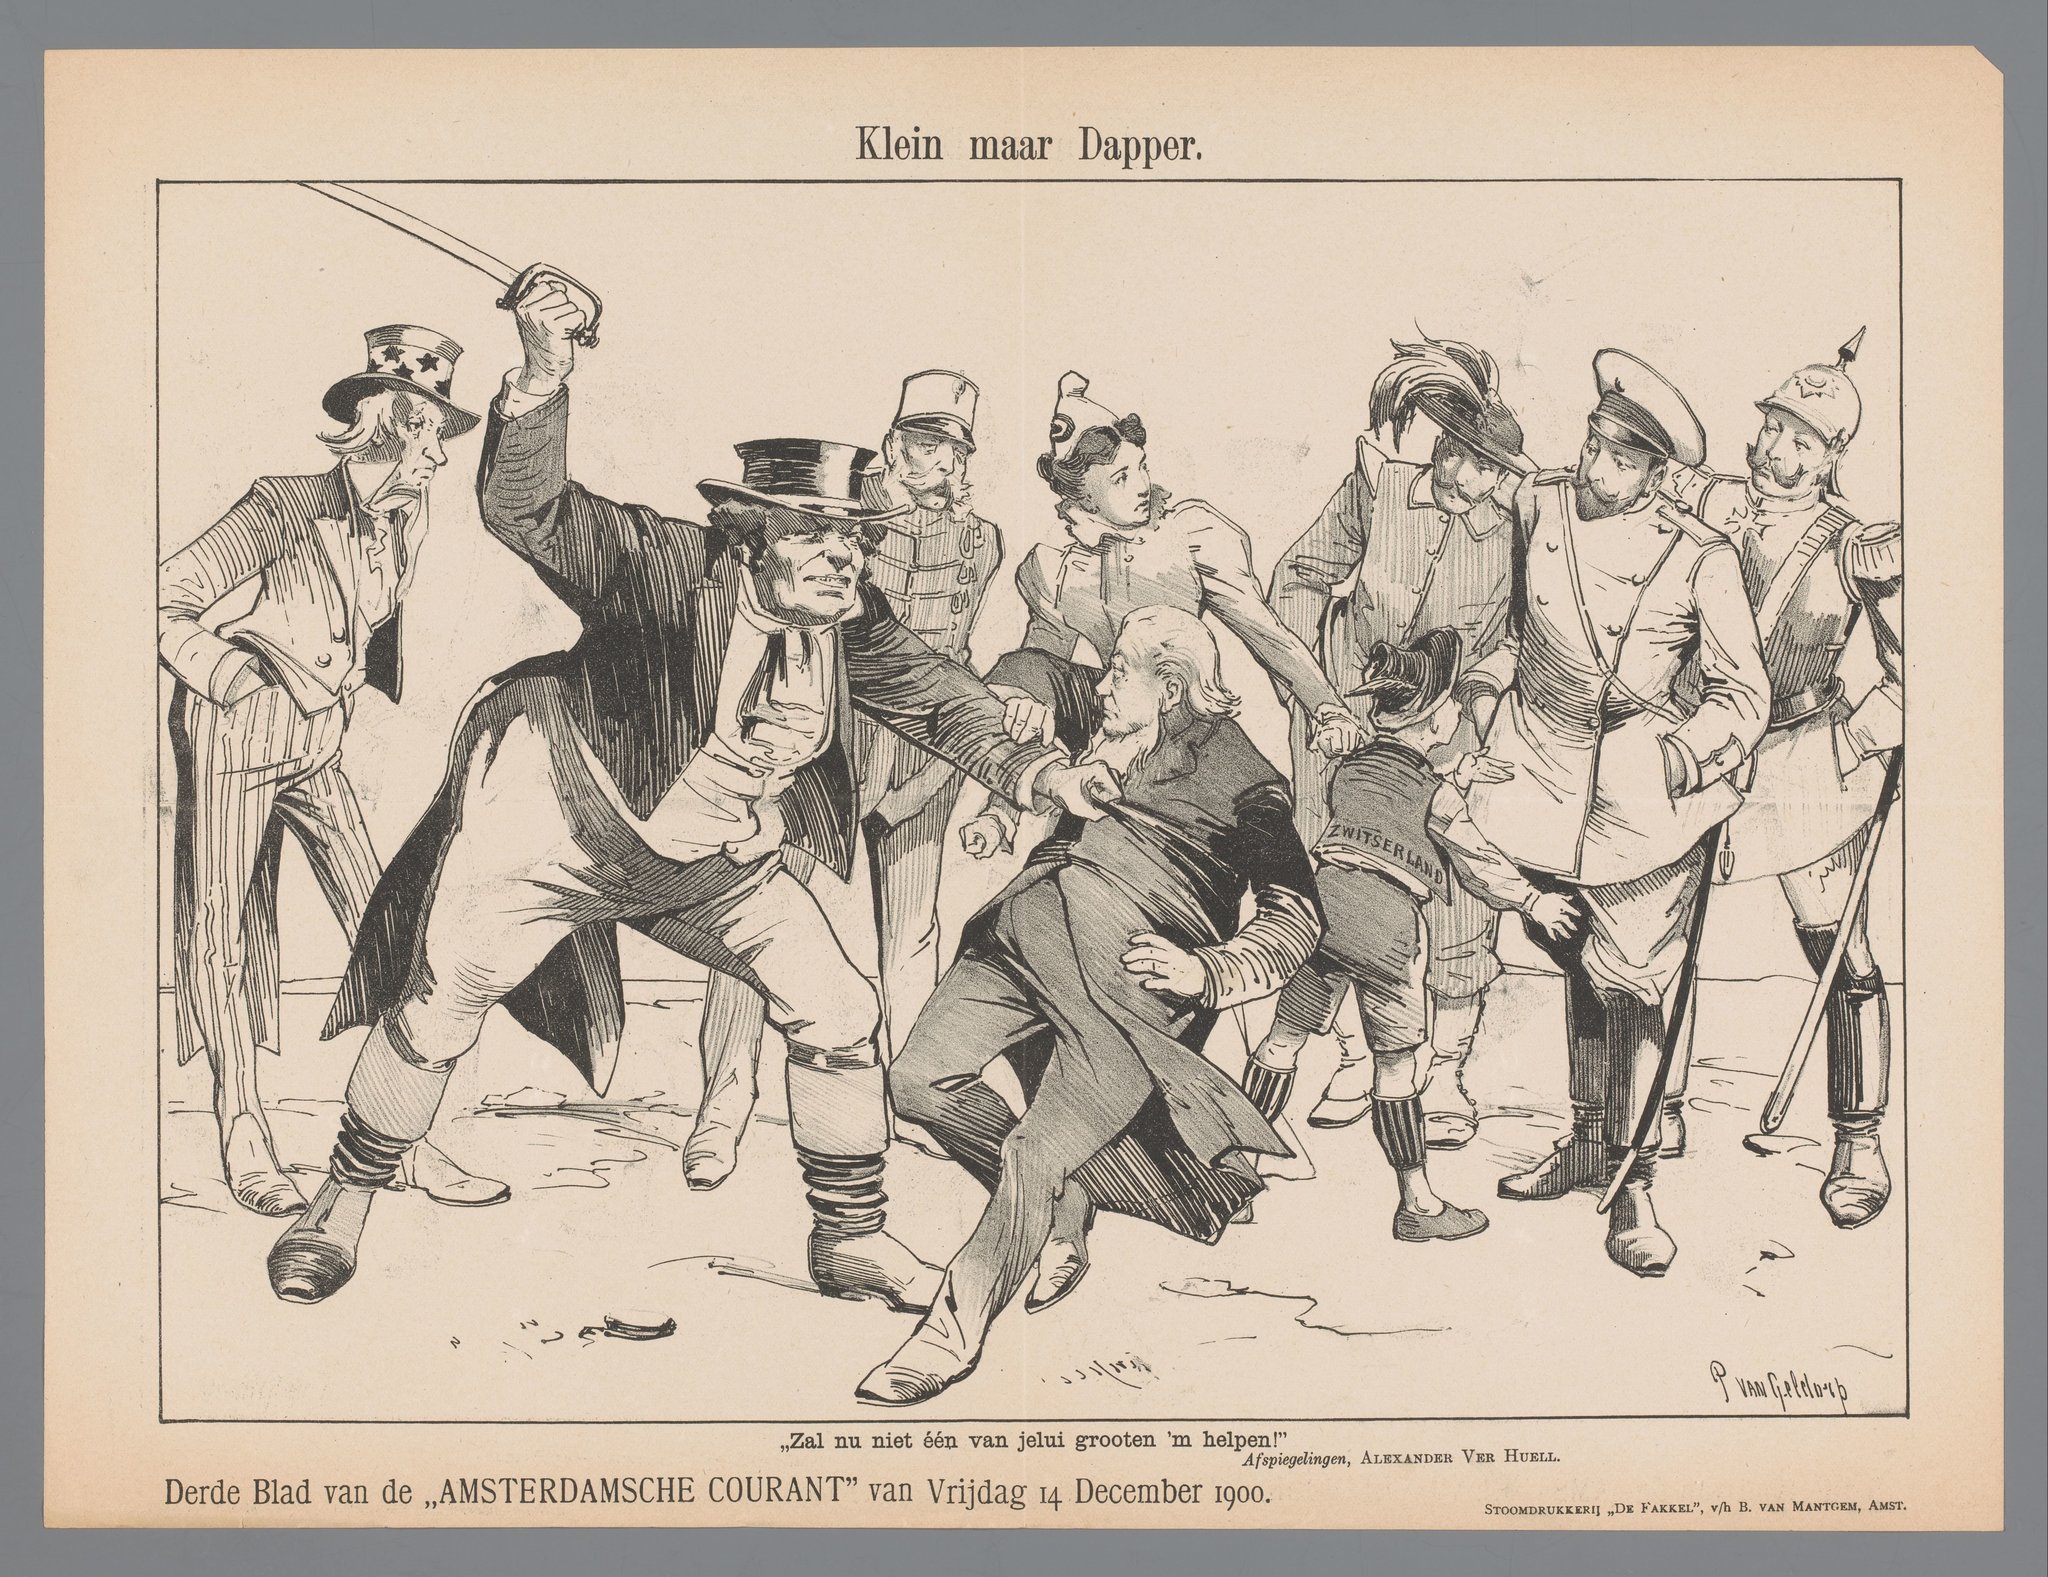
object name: cartoon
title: Klein maar Dapper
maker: petrus van geldorp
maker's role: draughtsman, print maker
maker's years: 1872-1939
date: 1900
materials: paper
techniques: lithograph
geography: amsterdam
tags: personifications of countries, nations, states, districts, etc., historical persons, politician, e.g. party leader, ruler, sovereign, political caricatures and satires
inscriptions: date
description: Prent uit het bijvoegsel van: De Amsterdamsche Courant, 14 december 1900.